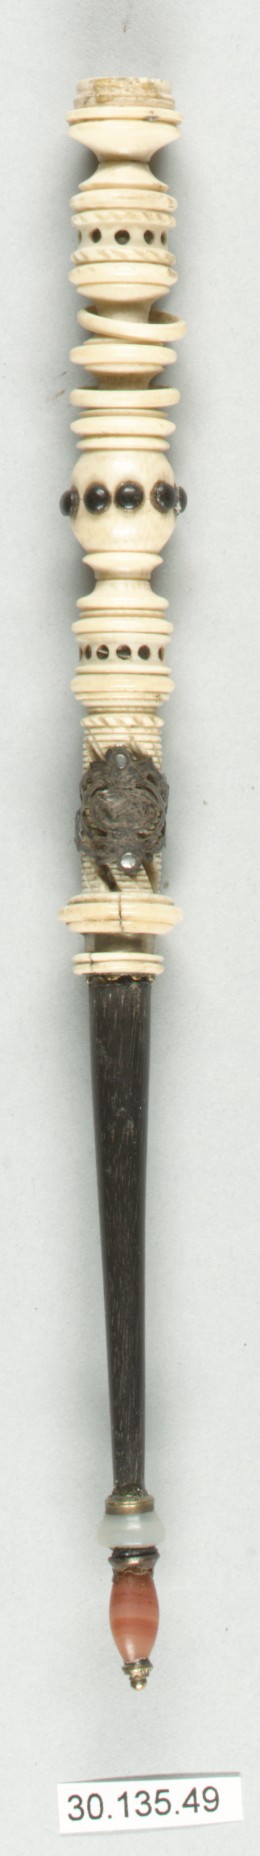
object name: needle sheath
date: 1701-1800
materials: bone, metal, wood